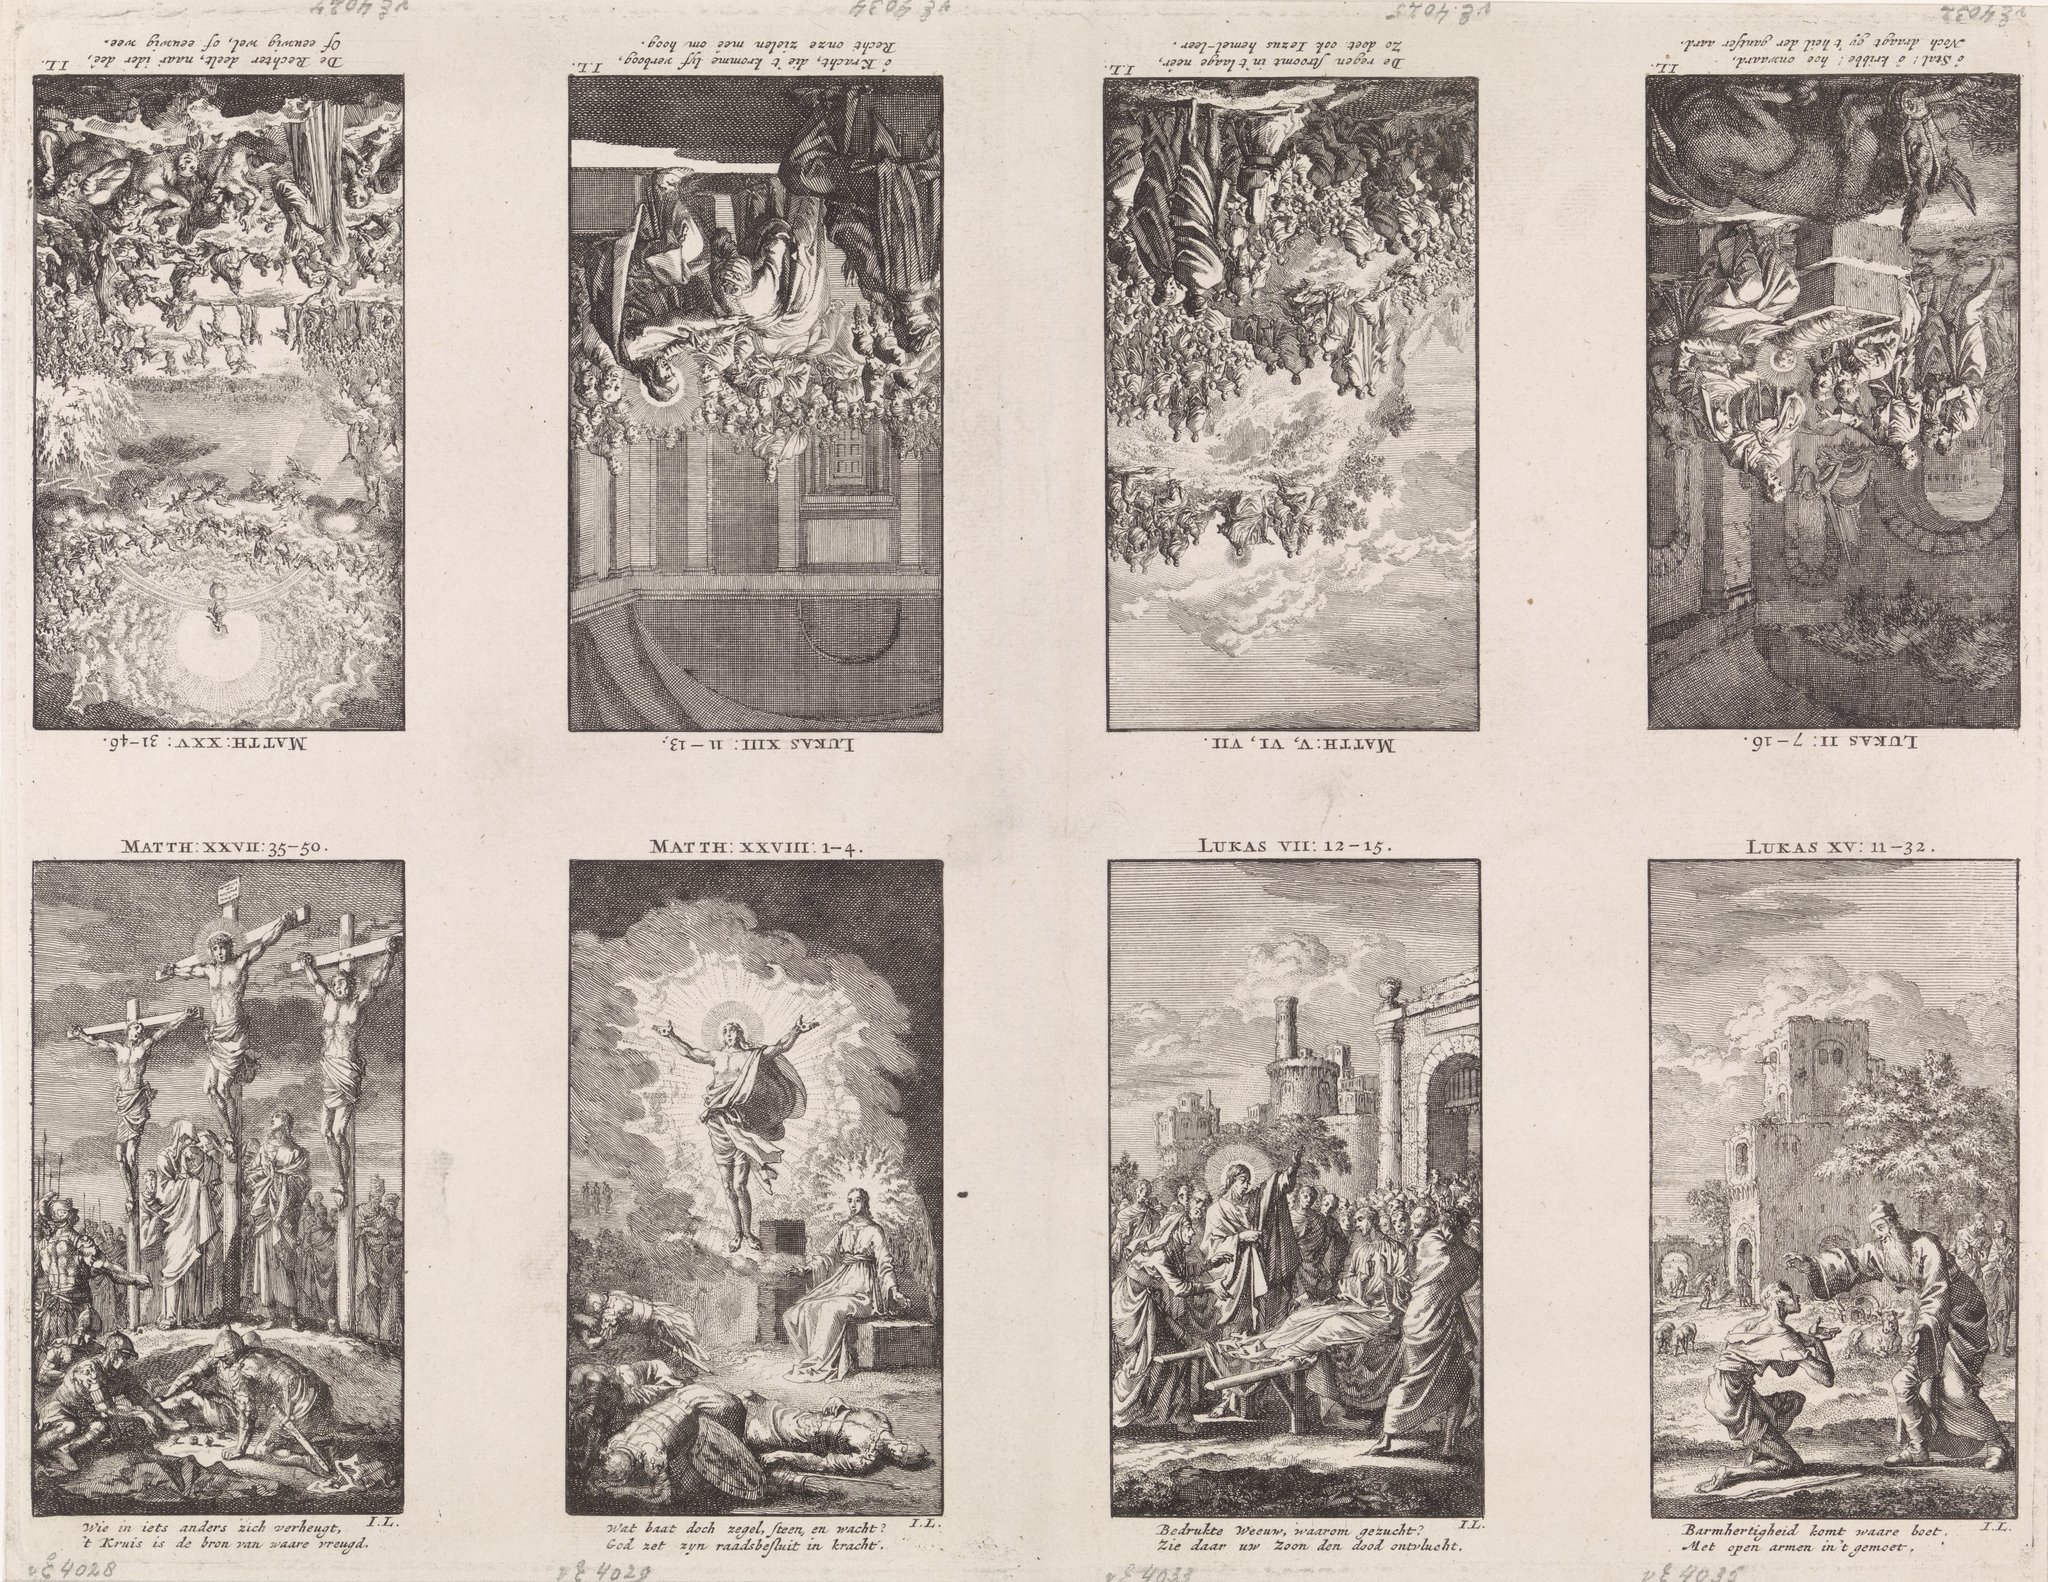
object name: print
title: Blad met acht scènes uit het Nieuwe Testament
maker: jan luyken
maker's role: draughtsman, print maker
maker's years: 1649-1712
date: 1712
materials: paper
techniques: etching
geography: amsterdam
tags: adoration of the christ-child by the shepherds; mary and joseph present, comprehensive representations of the events on golgotha during christ's hanging on the cross, no particular event emphasized, last judgement, christ's sermon on the mount (matthew 5-7), christ touches the bier of the son of the widow of nain: the young man sits up, christ, usually holding a banner, arises from the grave; often combined with sleeping and/or frightened soldiers, the parable of the prodigal son (luke 15:11-32), healing of a woman 'bent over' (luke 13:10-17)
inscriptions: collector's mark: Lugt 2228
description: Illustratie voor: Luyken, Jan. Bybel printen. Amsterdam: Pieter Arentsz. II (wed.) en Cornelis van der Sys, 1712, p.